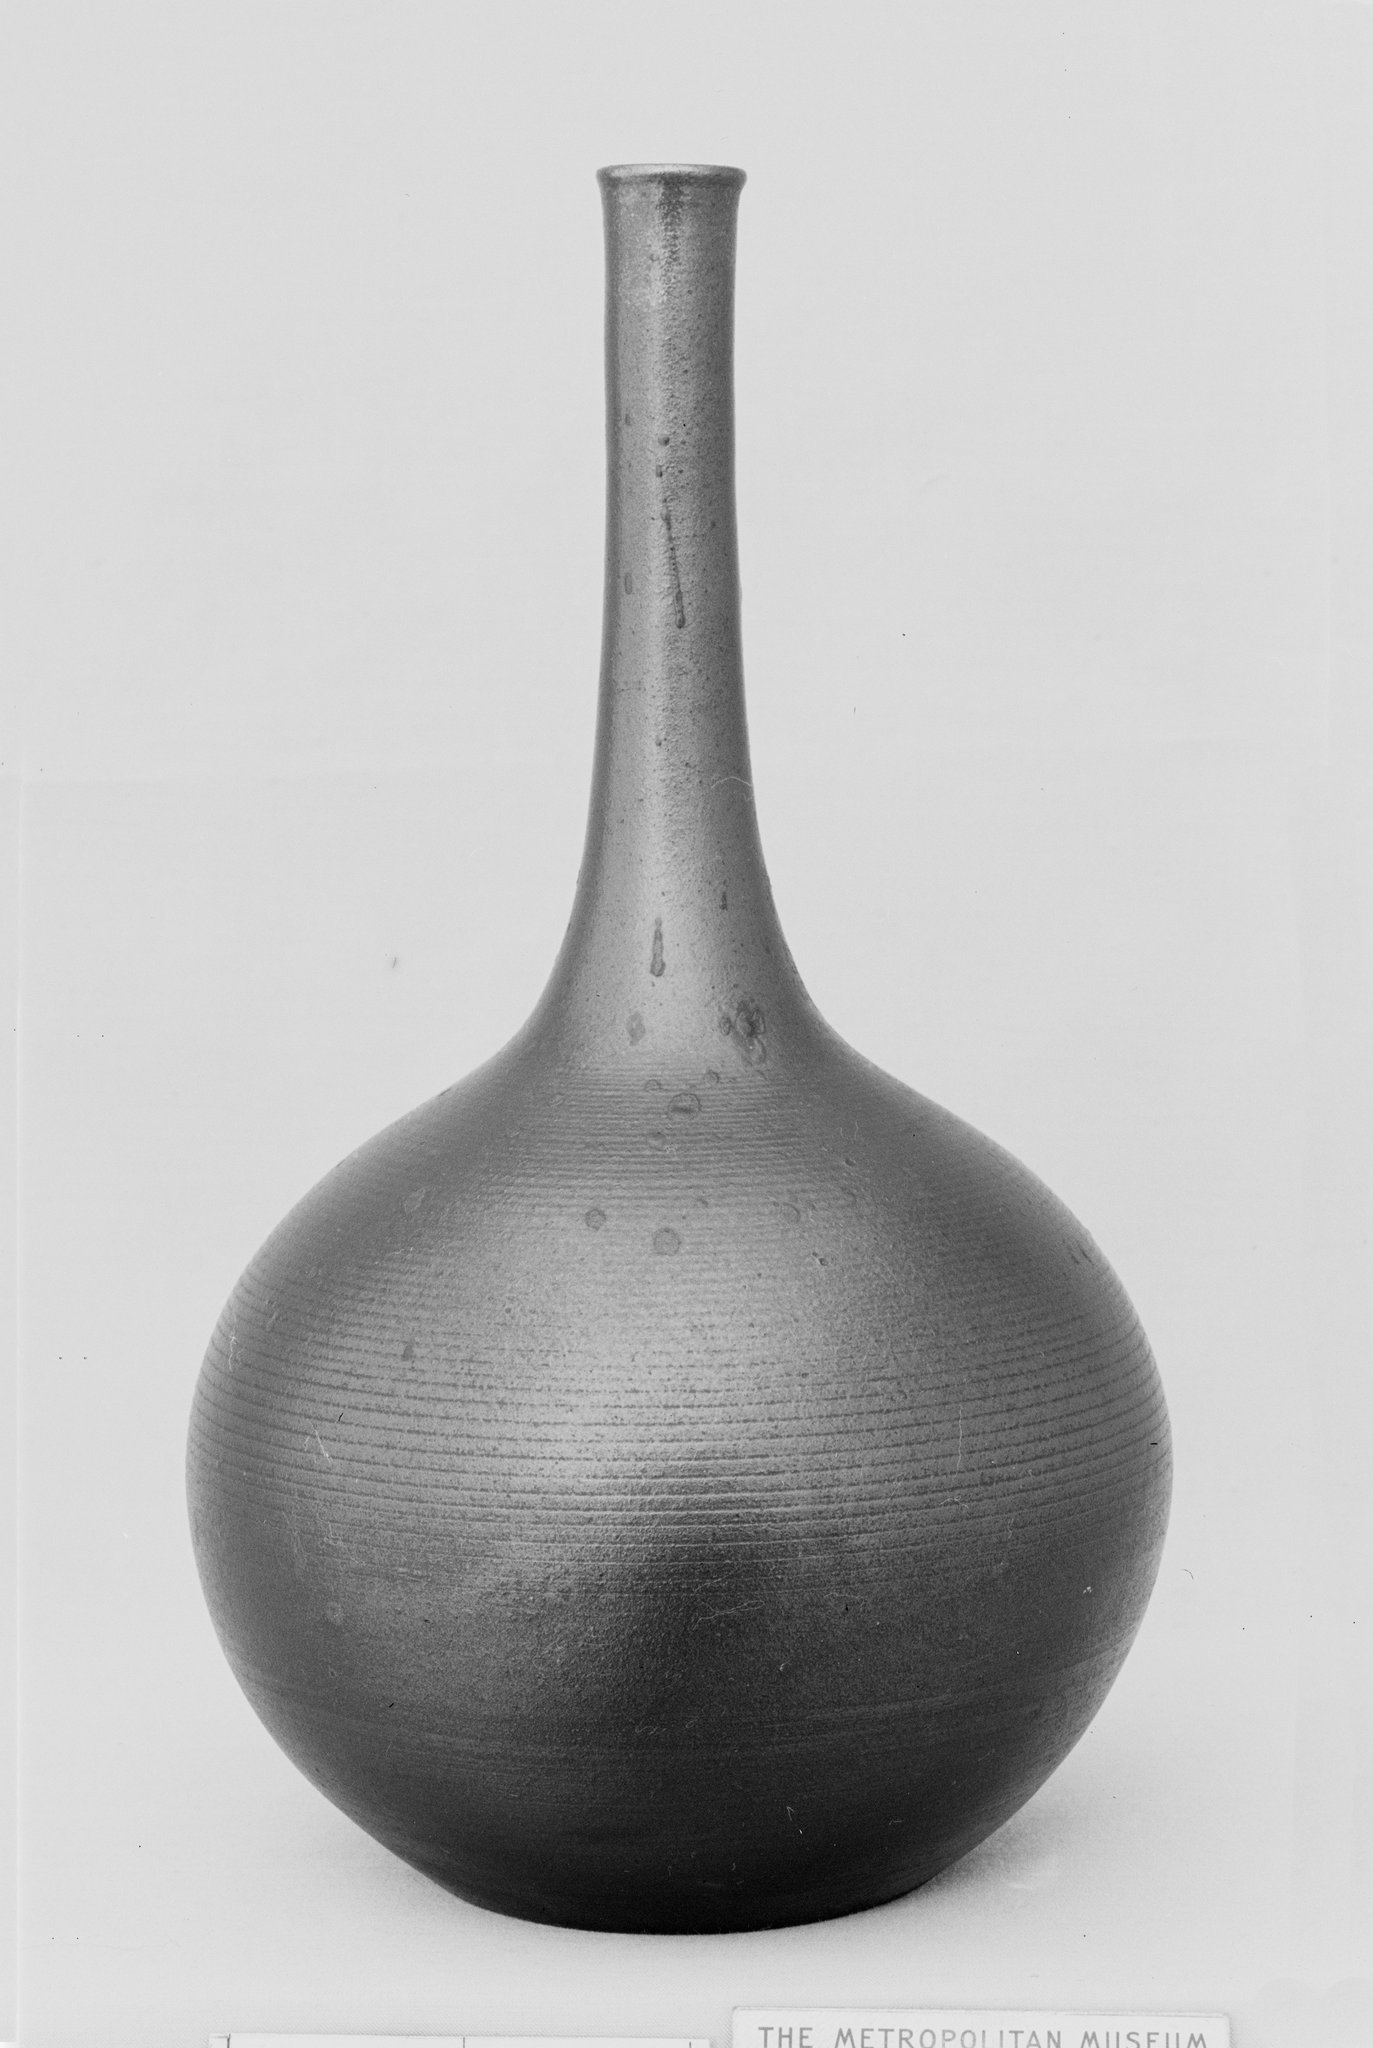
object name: wine bottle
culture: japanese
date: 1701-1800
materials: clay, glaze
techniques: overglaze